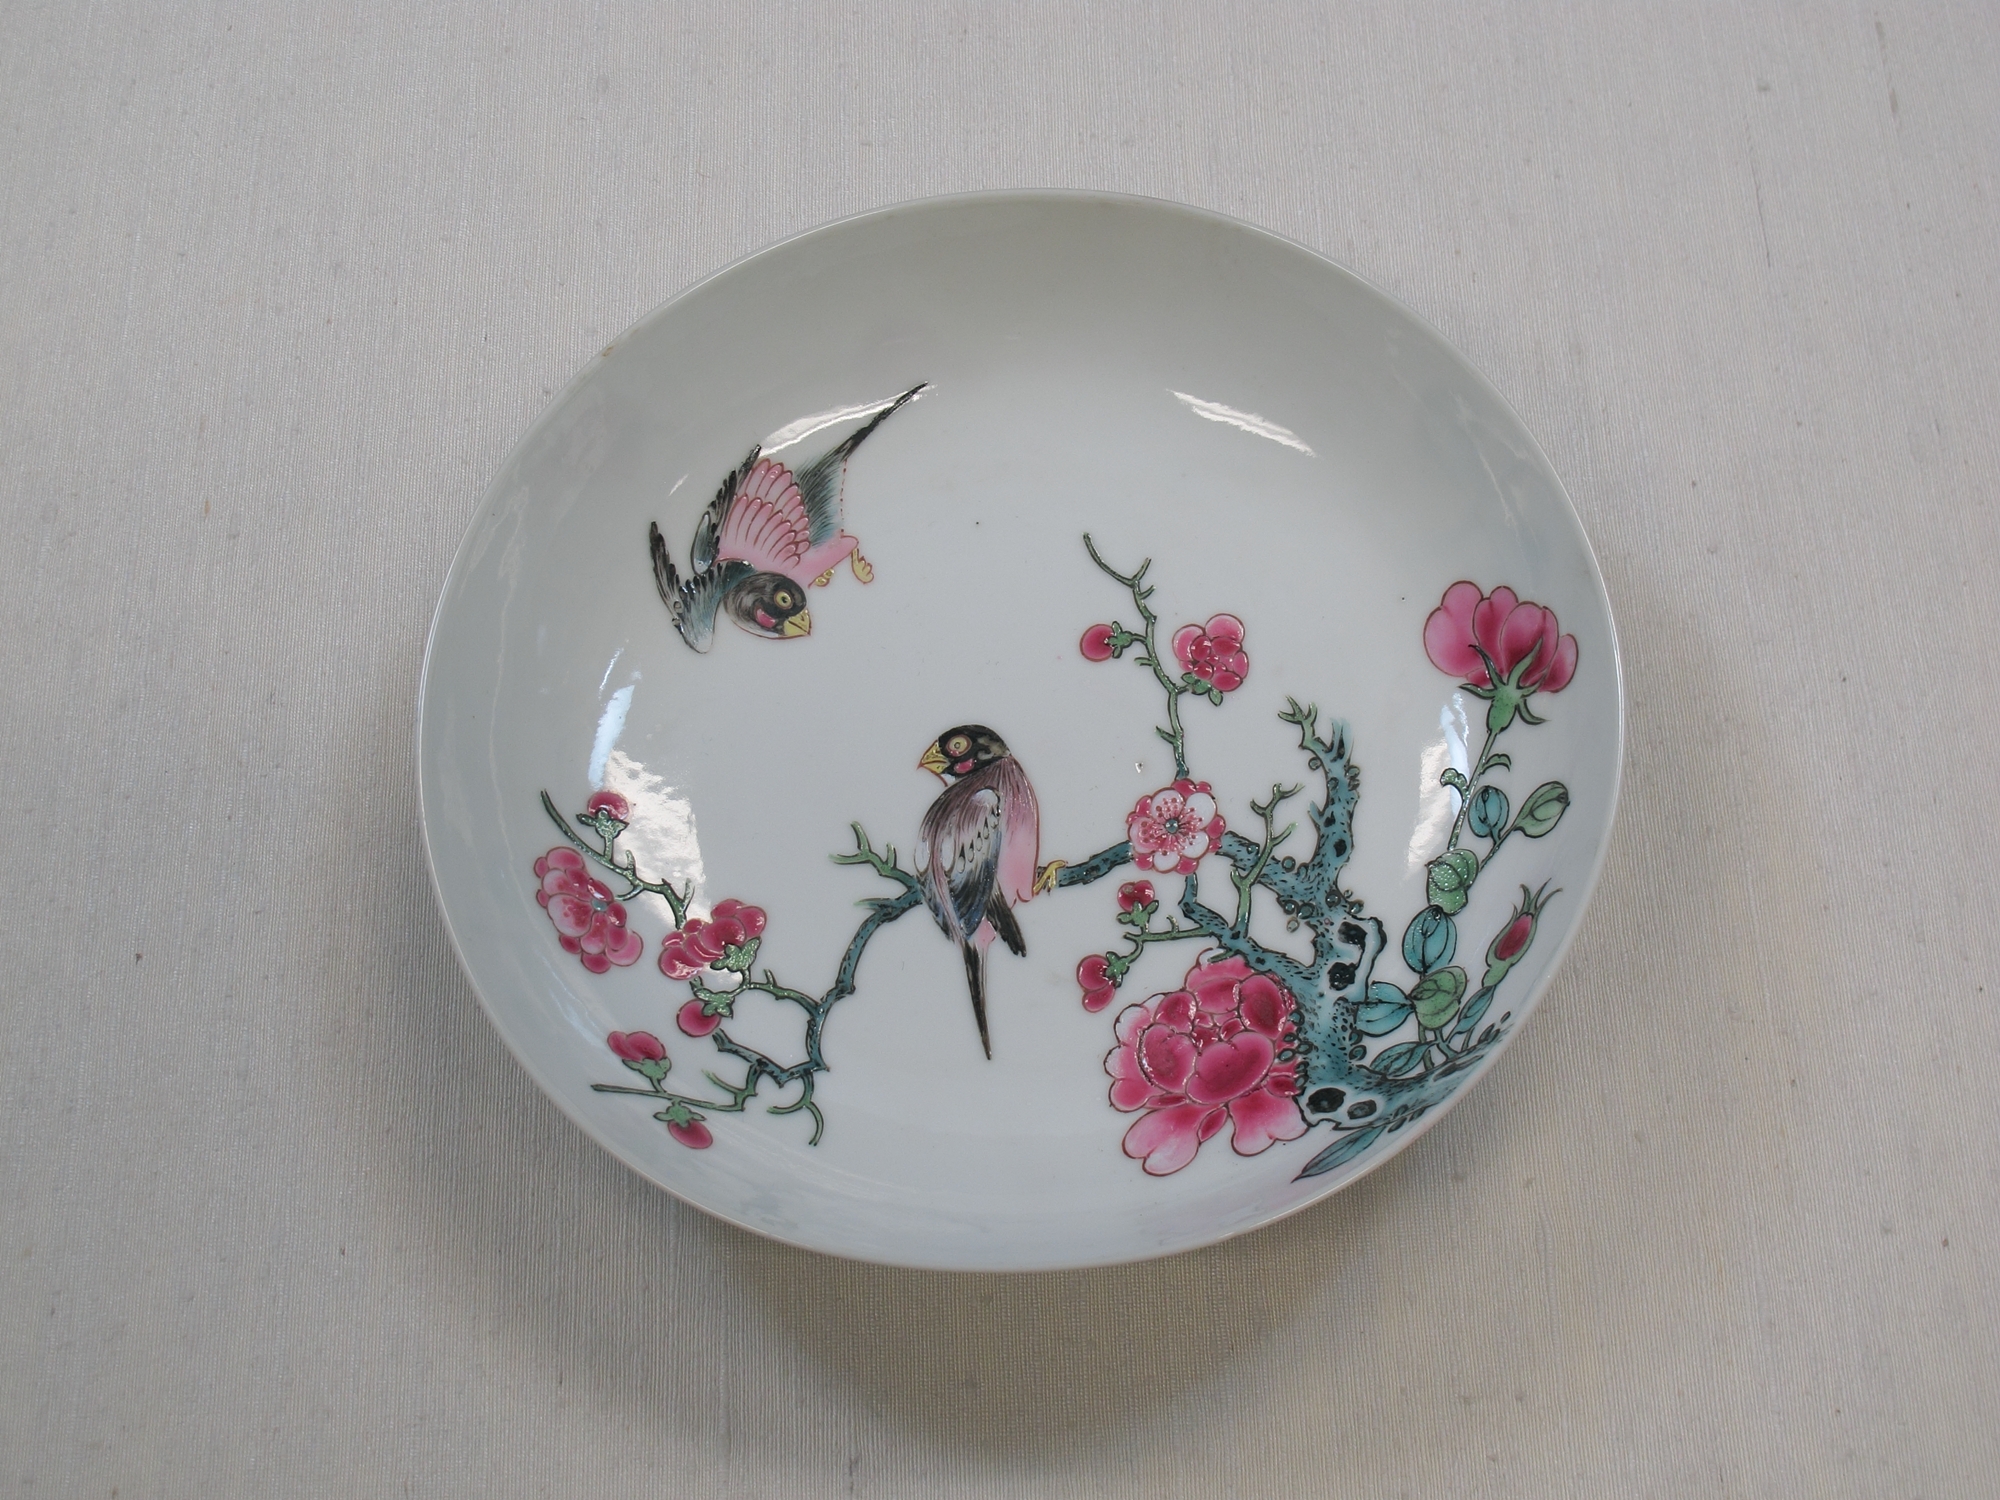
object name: saucer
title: Saucer with birds and flowers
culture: chinese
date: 1701-1800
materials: enamel, porcelain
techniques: overglaze, painting, polychrome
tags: birds,flowers